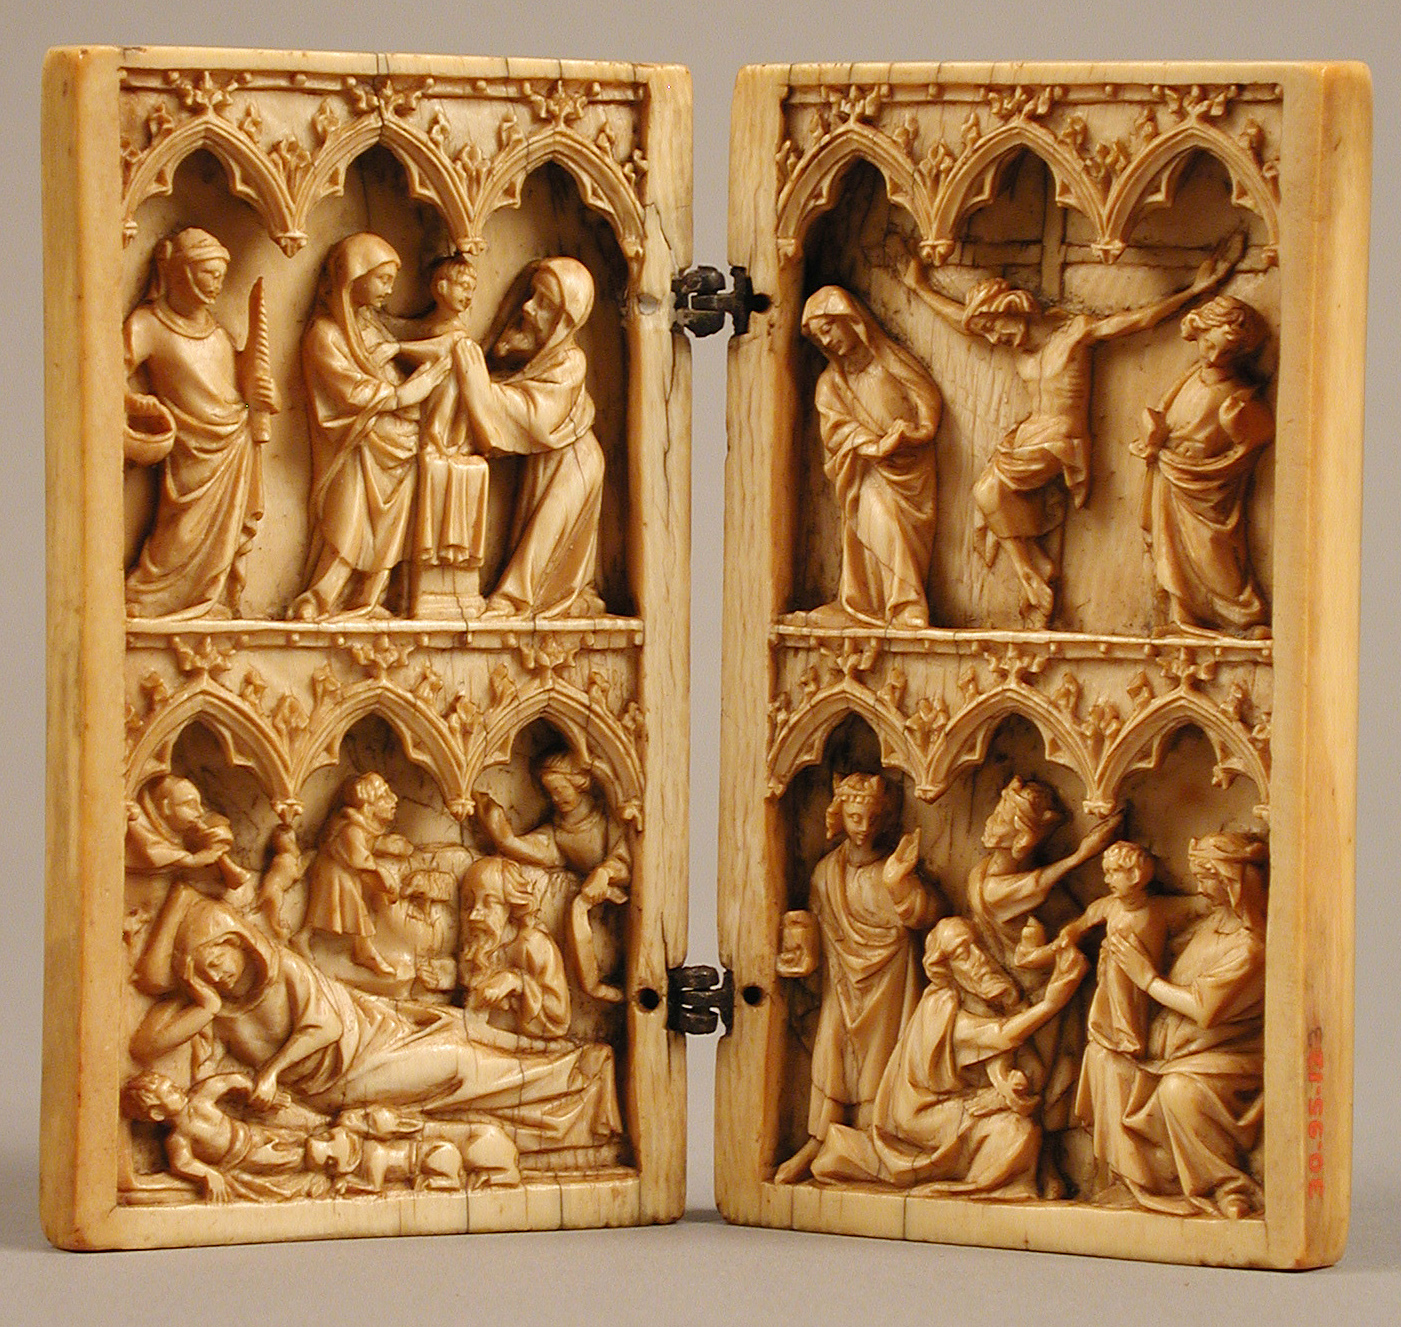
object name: diptych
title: Diptych with Scenes from the Life of Christ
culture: french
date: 1301-1400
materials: ivory, metal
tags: christ,virgin mary,adoration of the magi,crucifixion